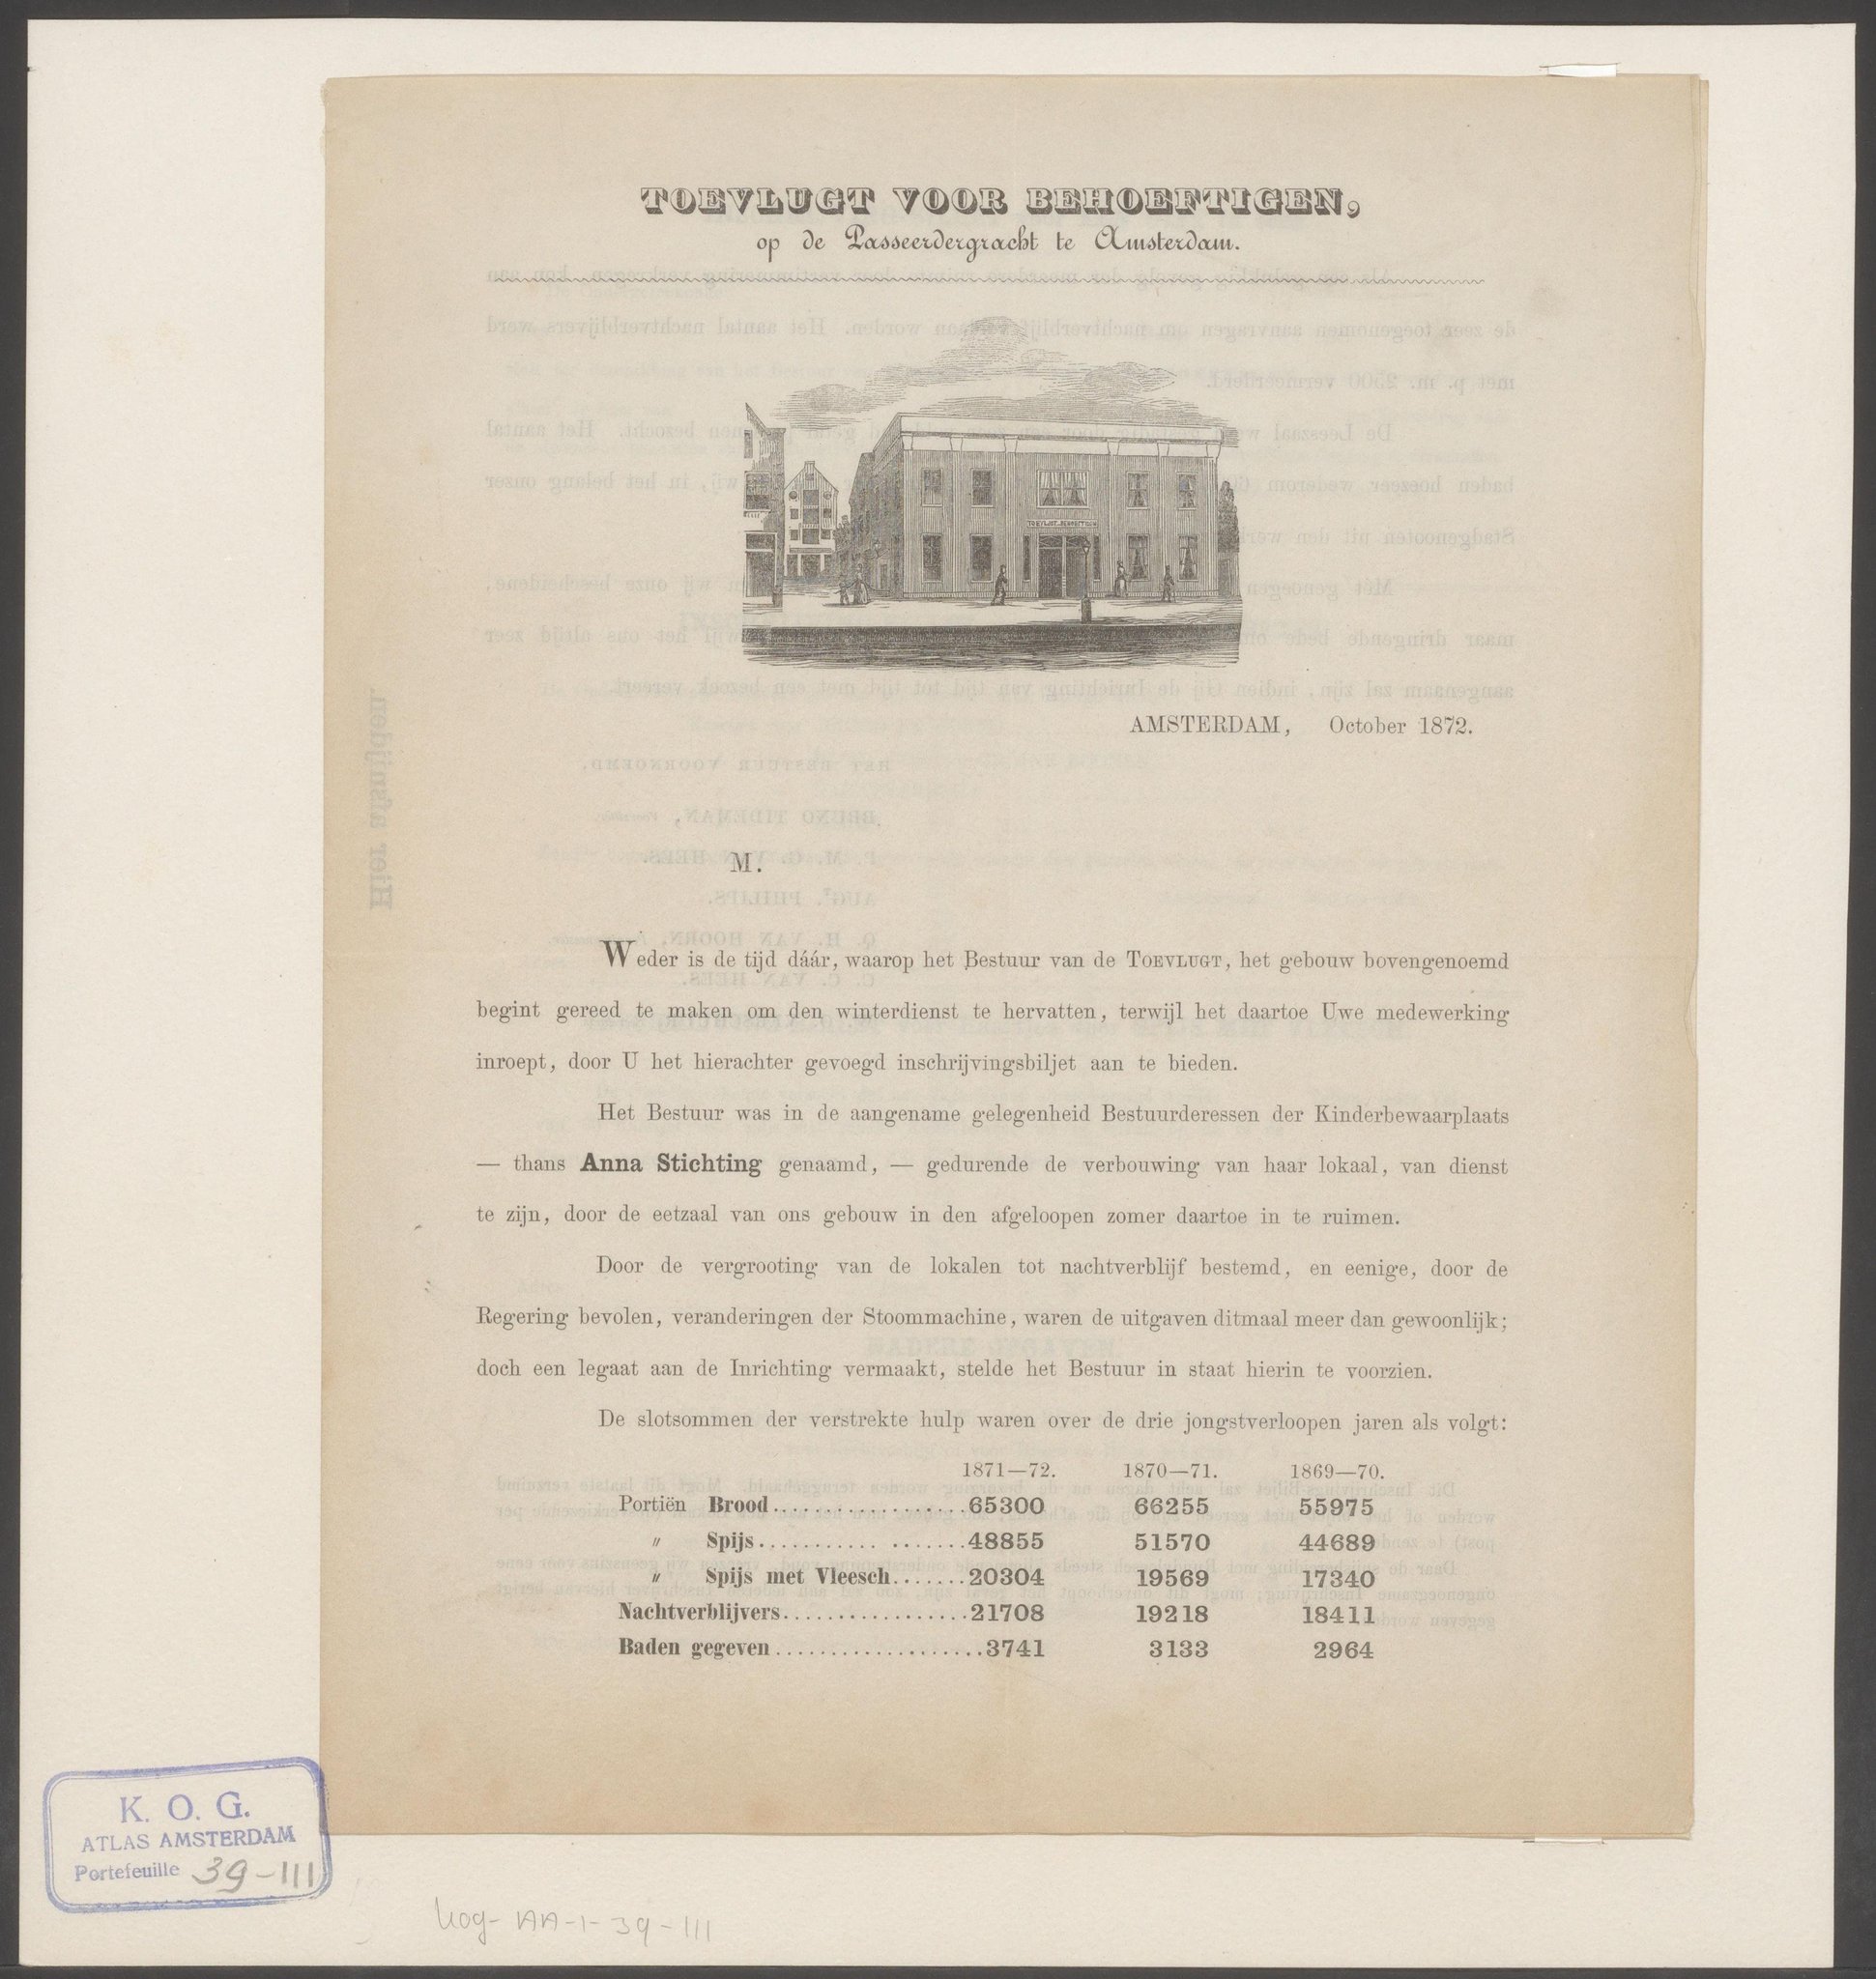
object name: print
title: Toevlugt voor Behoeftigen, op de Passeerdergracht te Amsterdam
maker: Anonymous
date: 1810-1872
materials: paper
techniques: letterpress printing, engraving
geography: netherlands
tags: public welfare, canals, waters (in city) (+ city(-scape) with figures, staffage)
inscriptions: collector's mark: Lugt 1641b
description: Object bestaat uit een bifolium. Onderwerpsrubriek binnen de Atlas Amsterdam: Armwezen en liefdadige instellingen: III. Verschillende gestichten en instellingen / Hofjes: Toevlucht voor Behoeftigen.